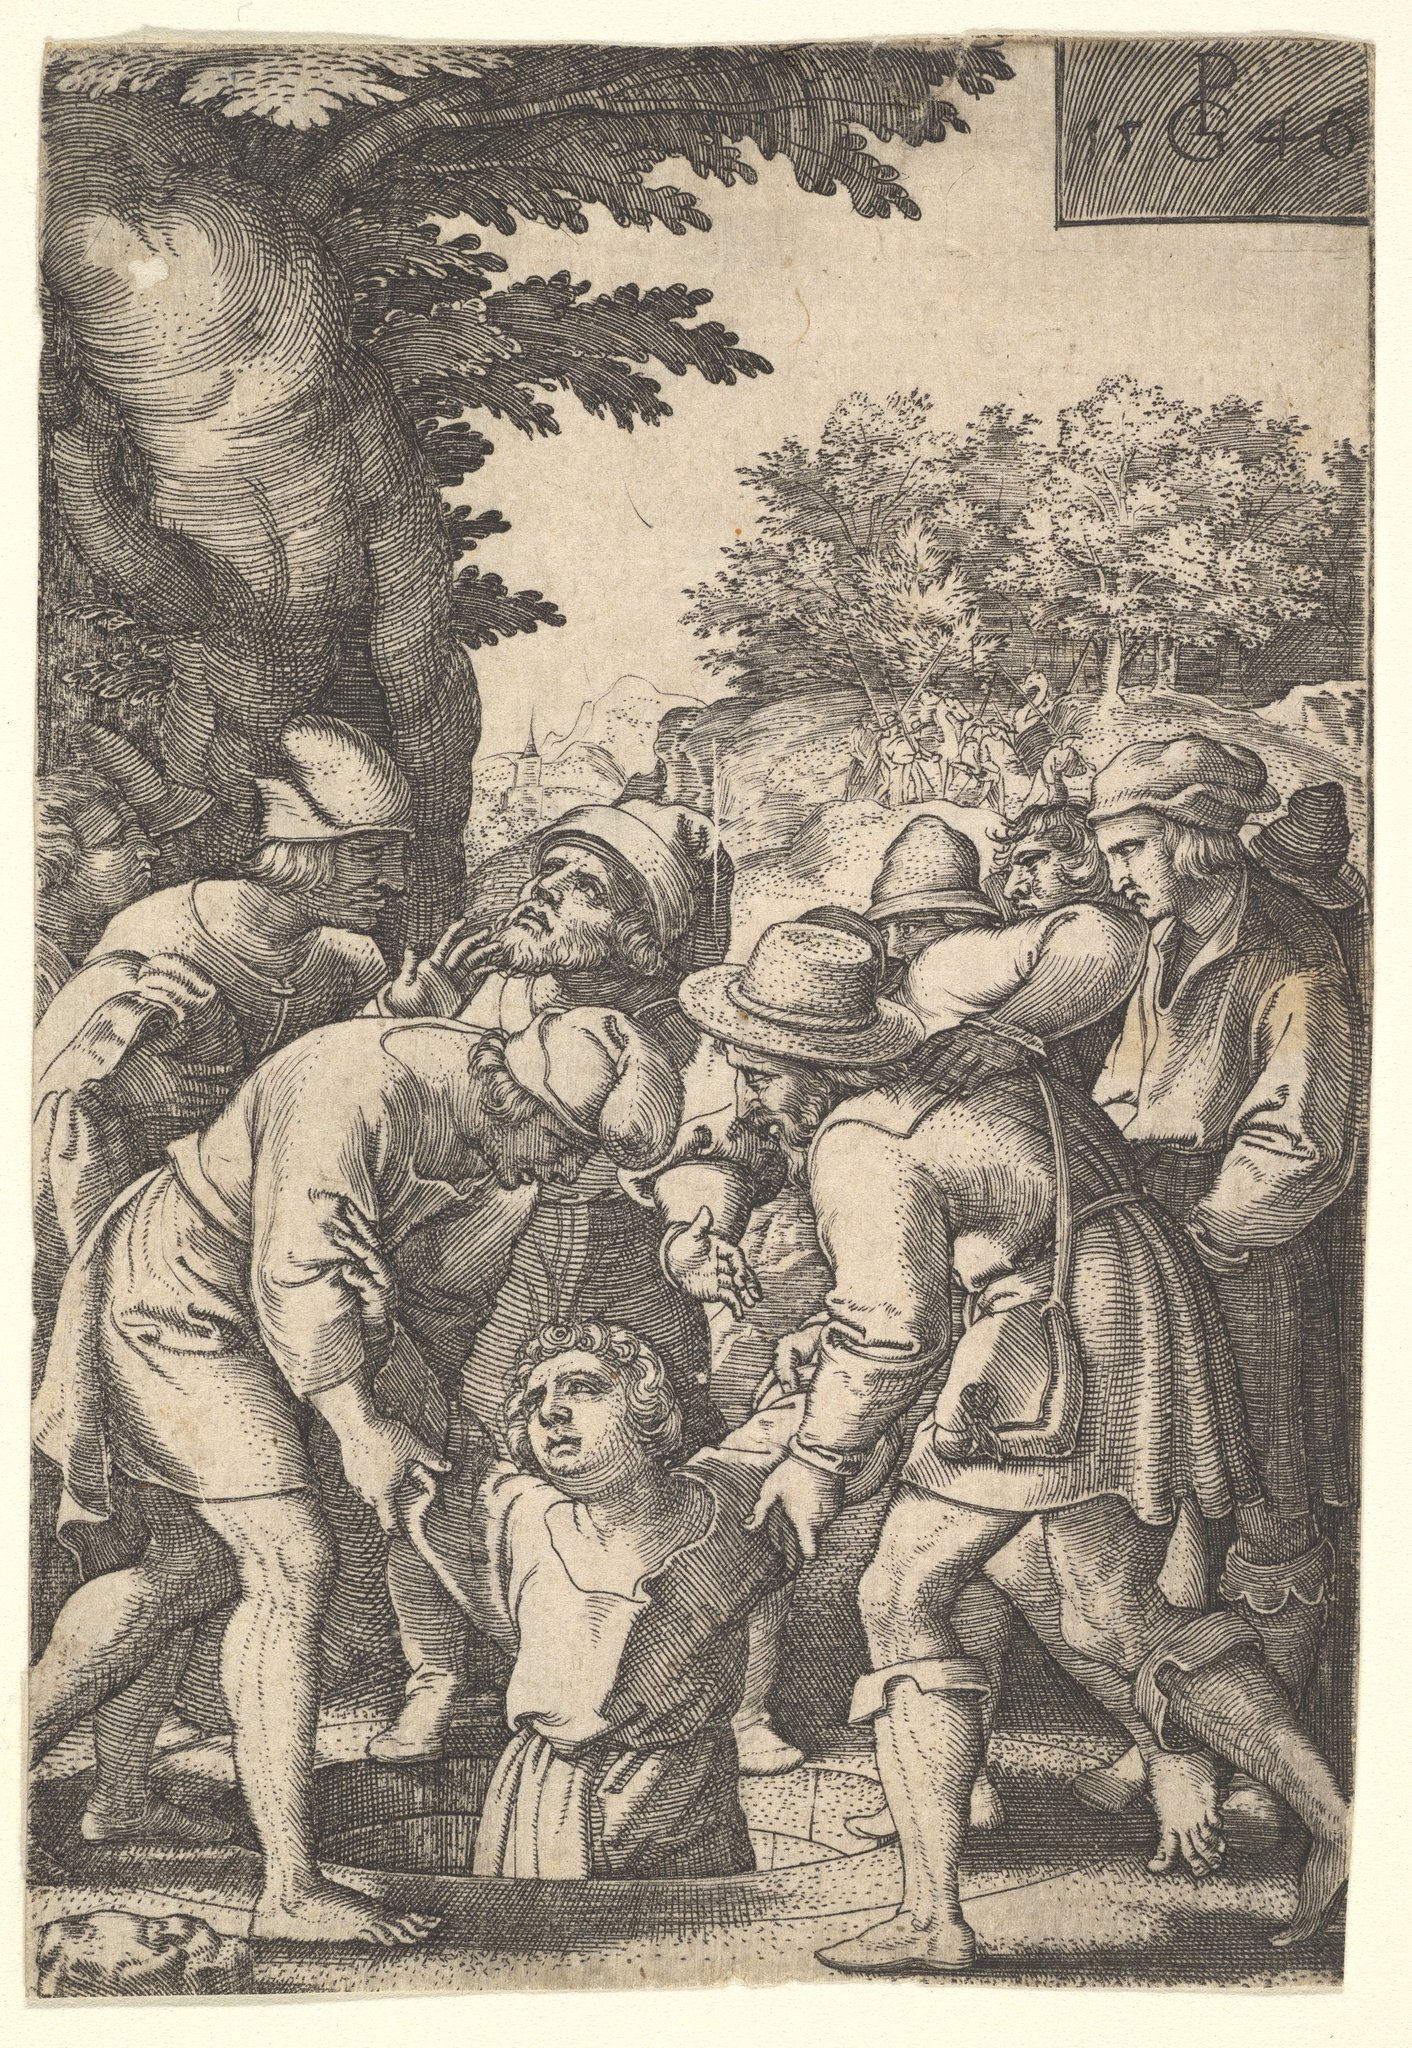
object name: print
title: Joseph lowered into a well by his brothers, from "The Story of Joseph"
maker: georg pencz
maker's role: artist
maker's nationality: german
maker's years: 1500-1550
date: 1546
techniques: engraving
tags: wells,men